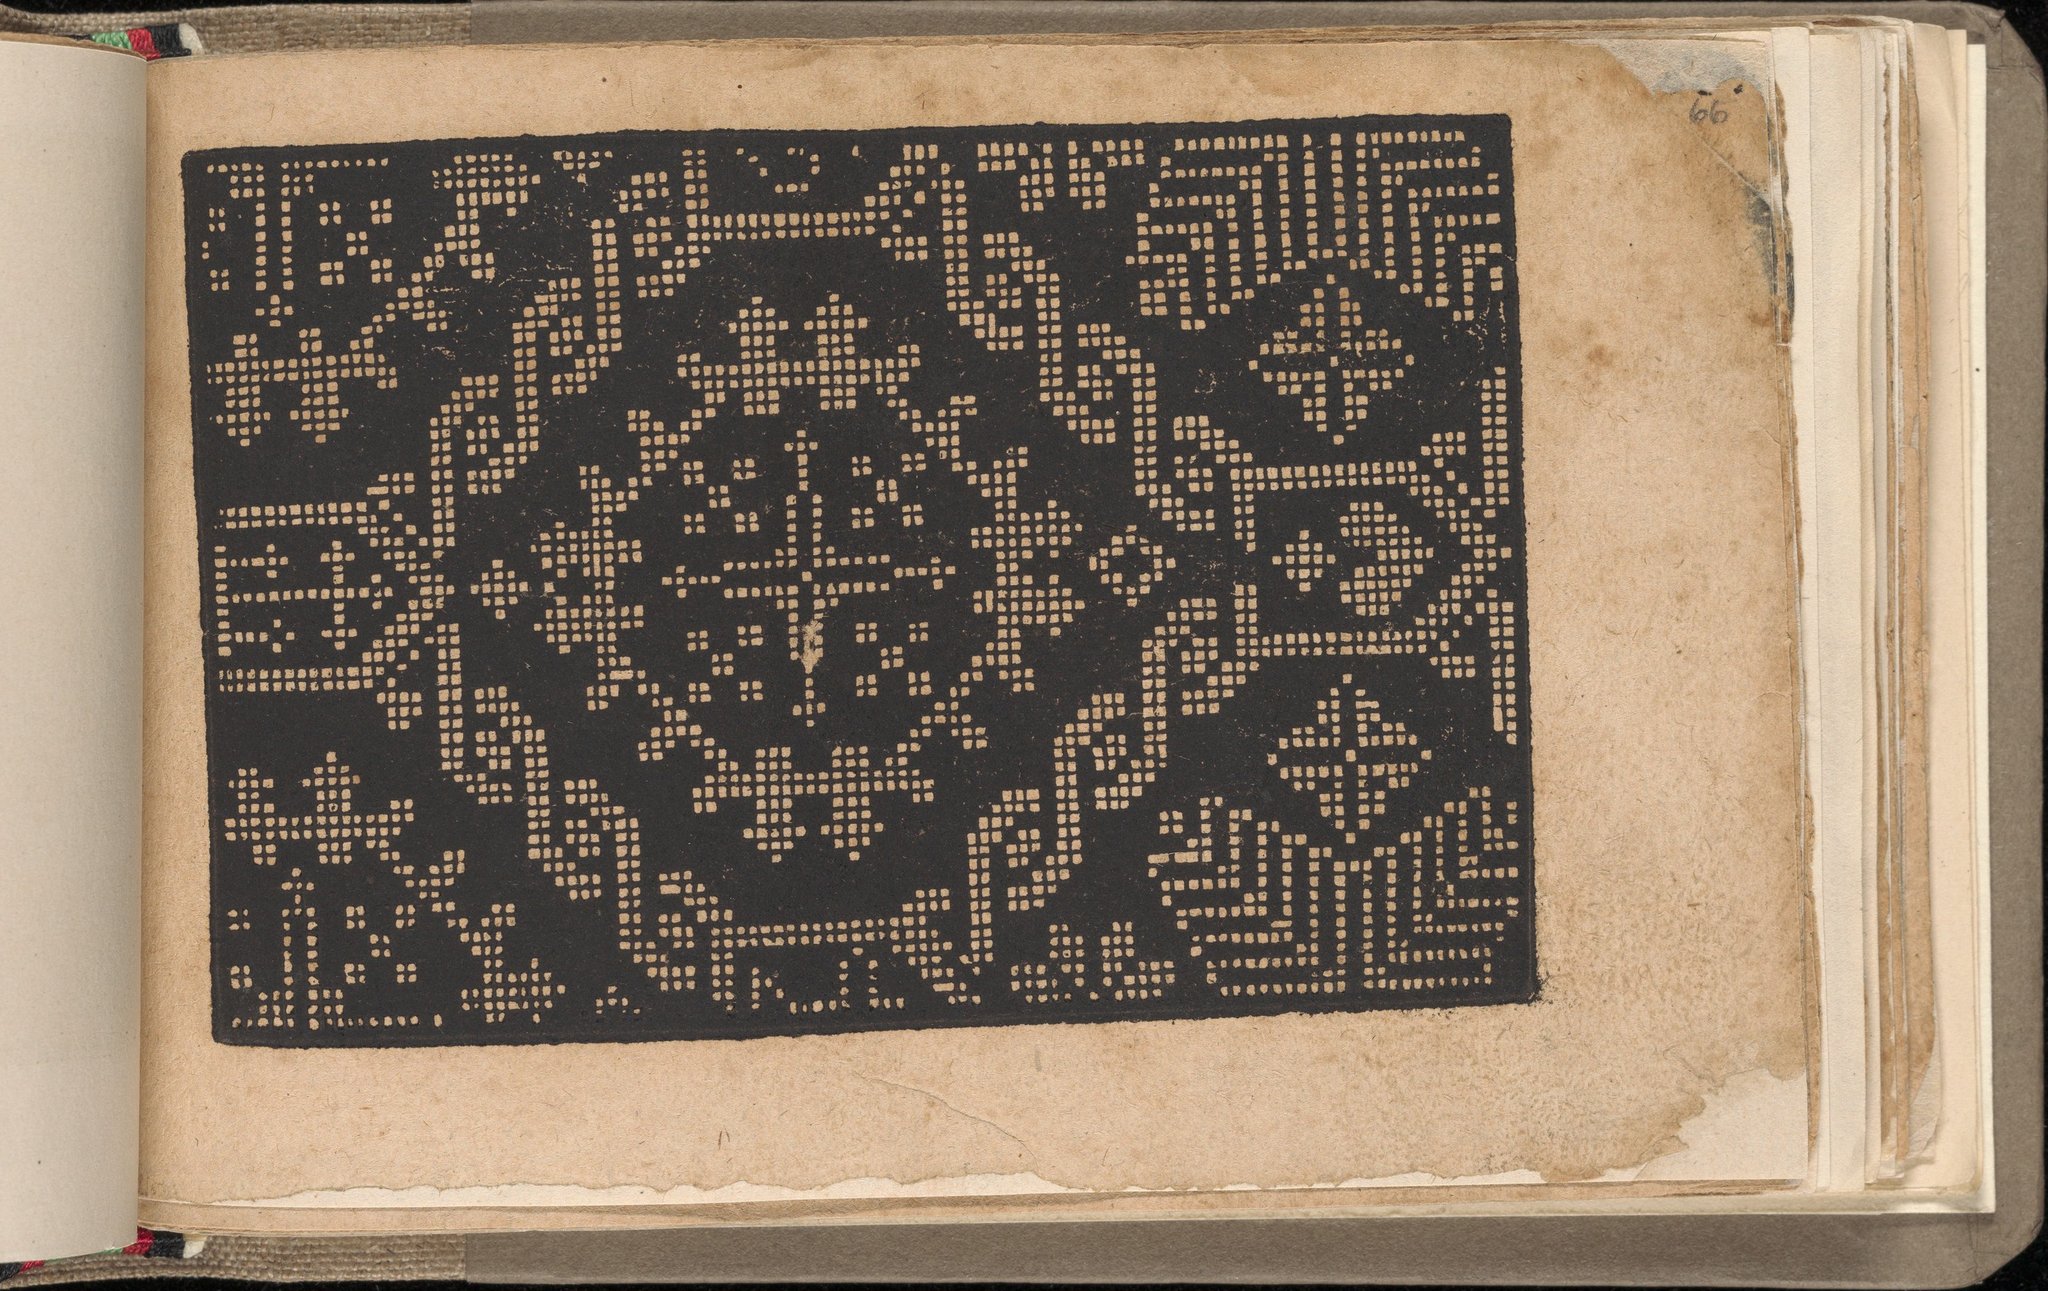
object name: book print ornament architecture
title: Schön newes Modelbuch (Page 66r)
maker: sigismundus latomus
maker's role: publisher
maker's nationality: german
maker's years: 1599-1632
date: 1608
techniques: woodcut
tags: ornament